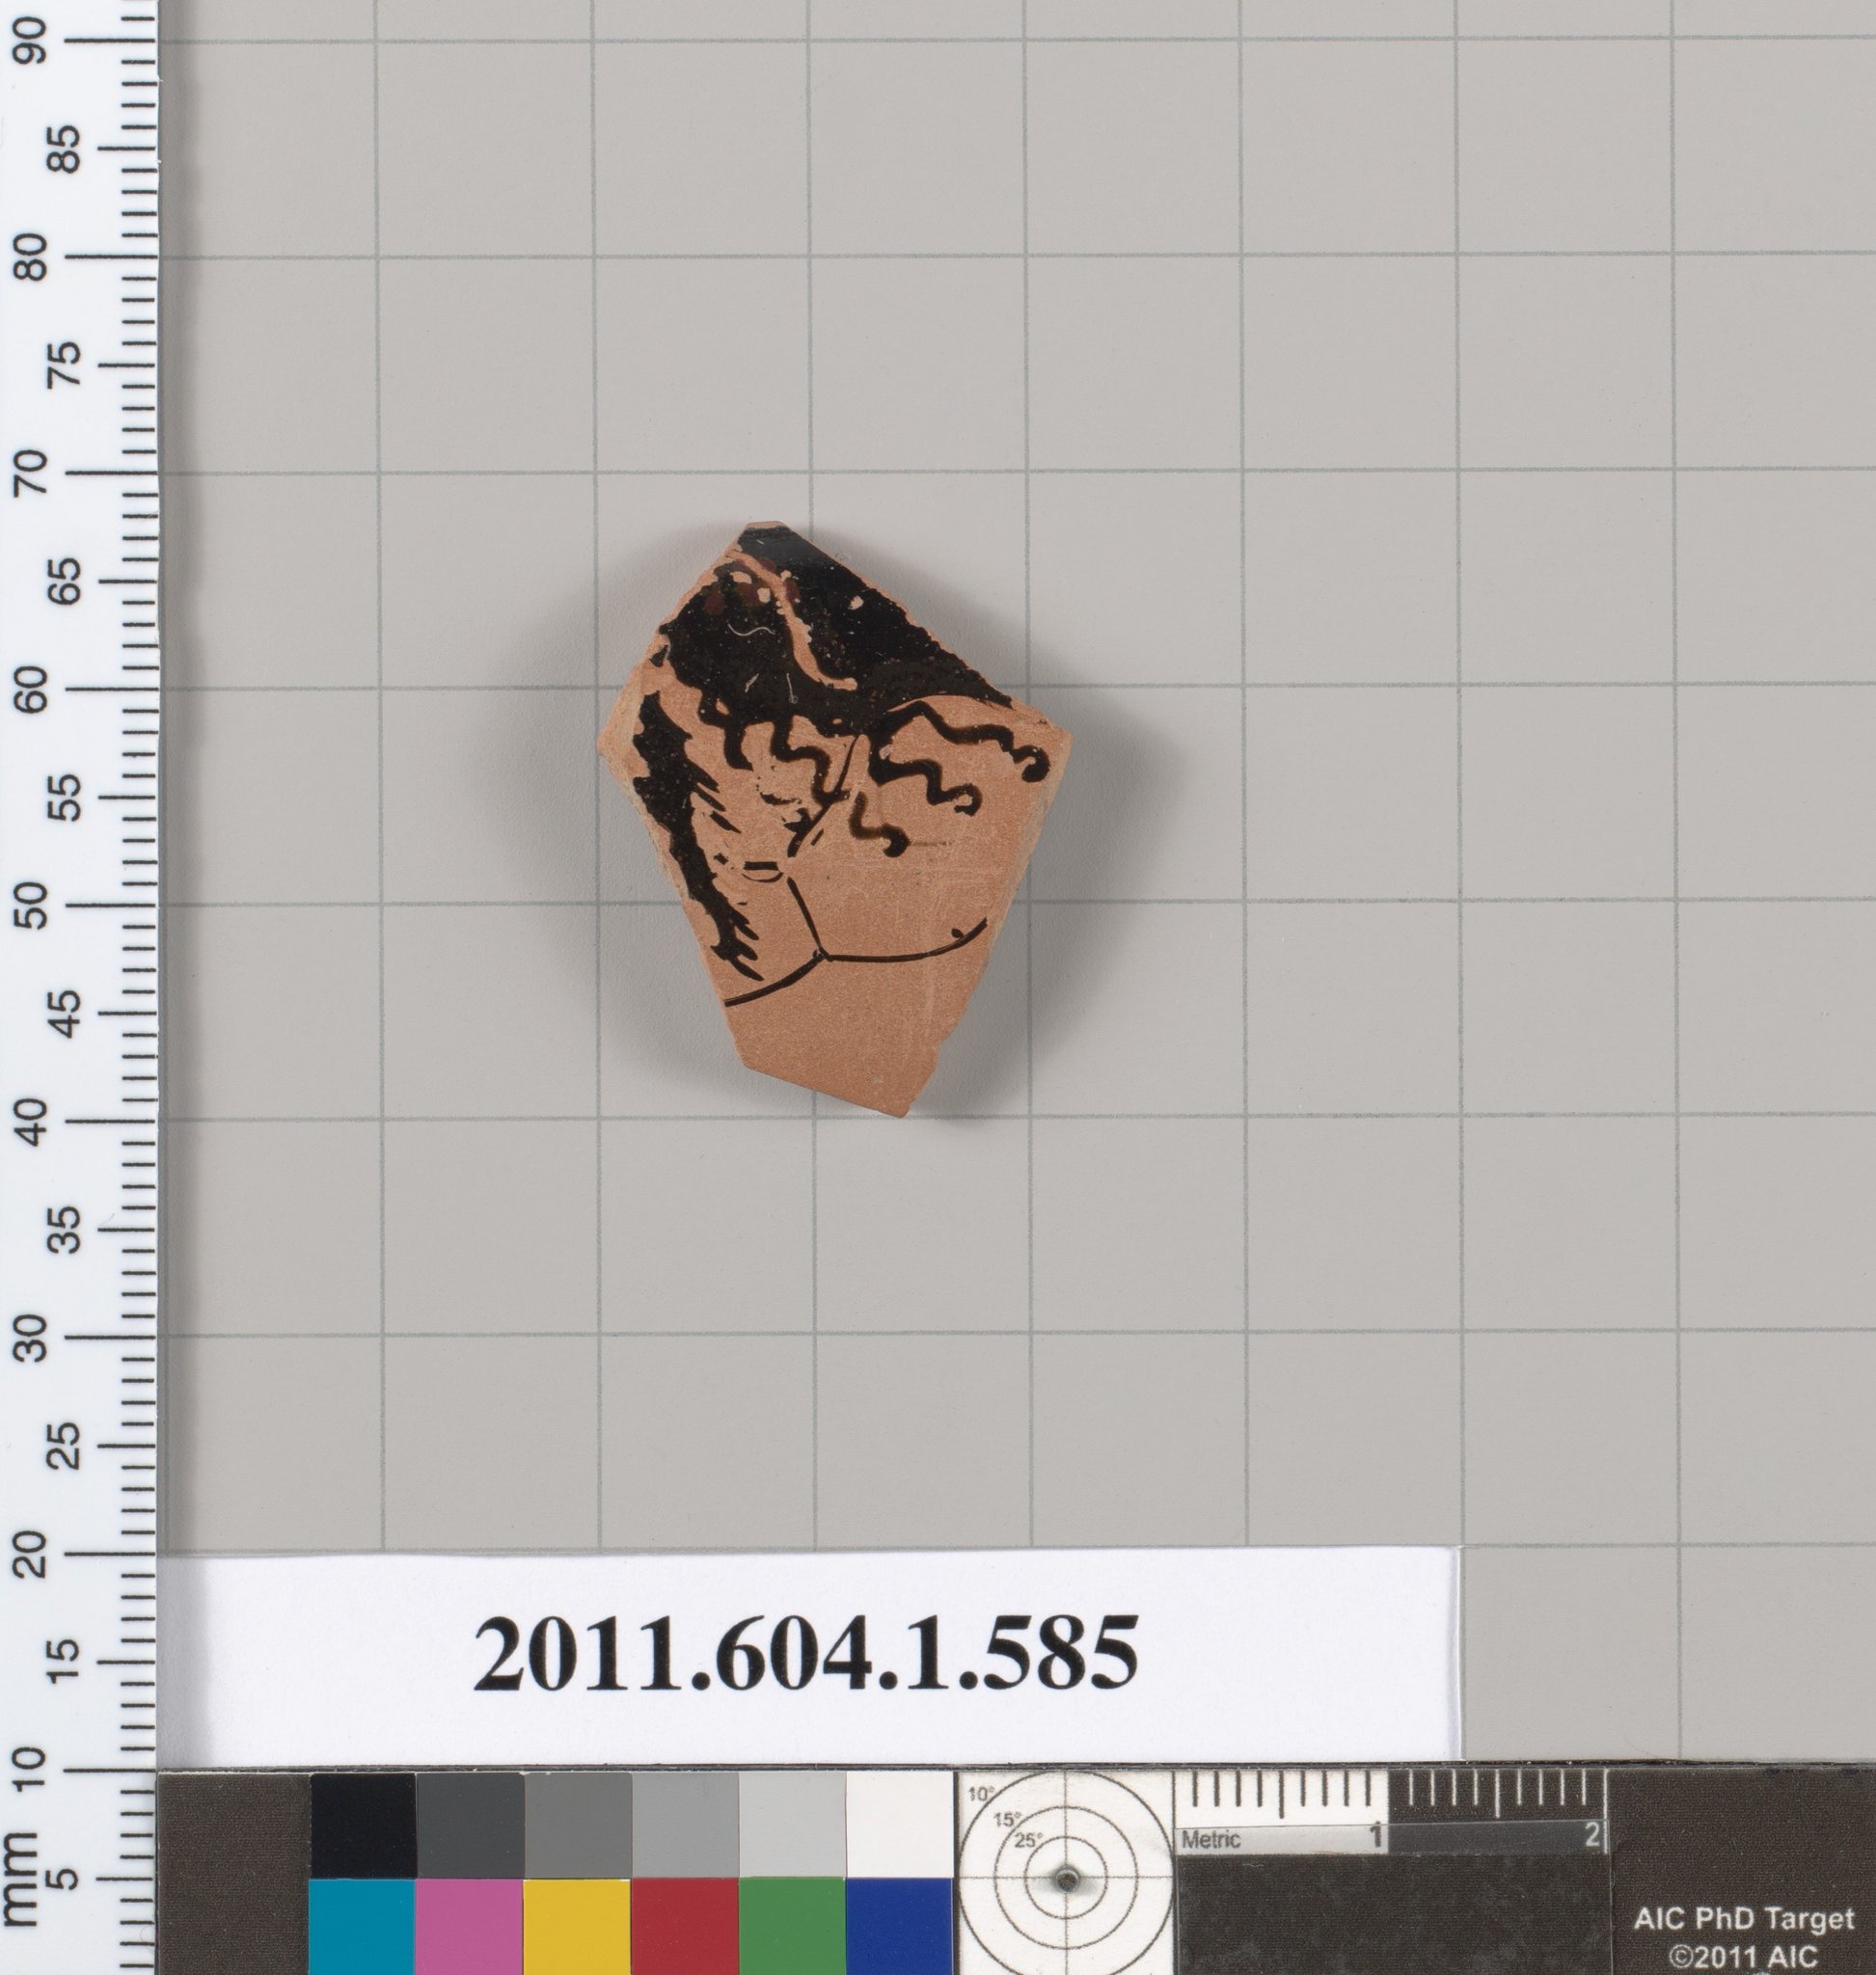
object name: kylix fragment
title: Terracotta fragment of a kylix (drinking cup)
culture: greek, attic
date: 450-401 BCE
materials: terracotta